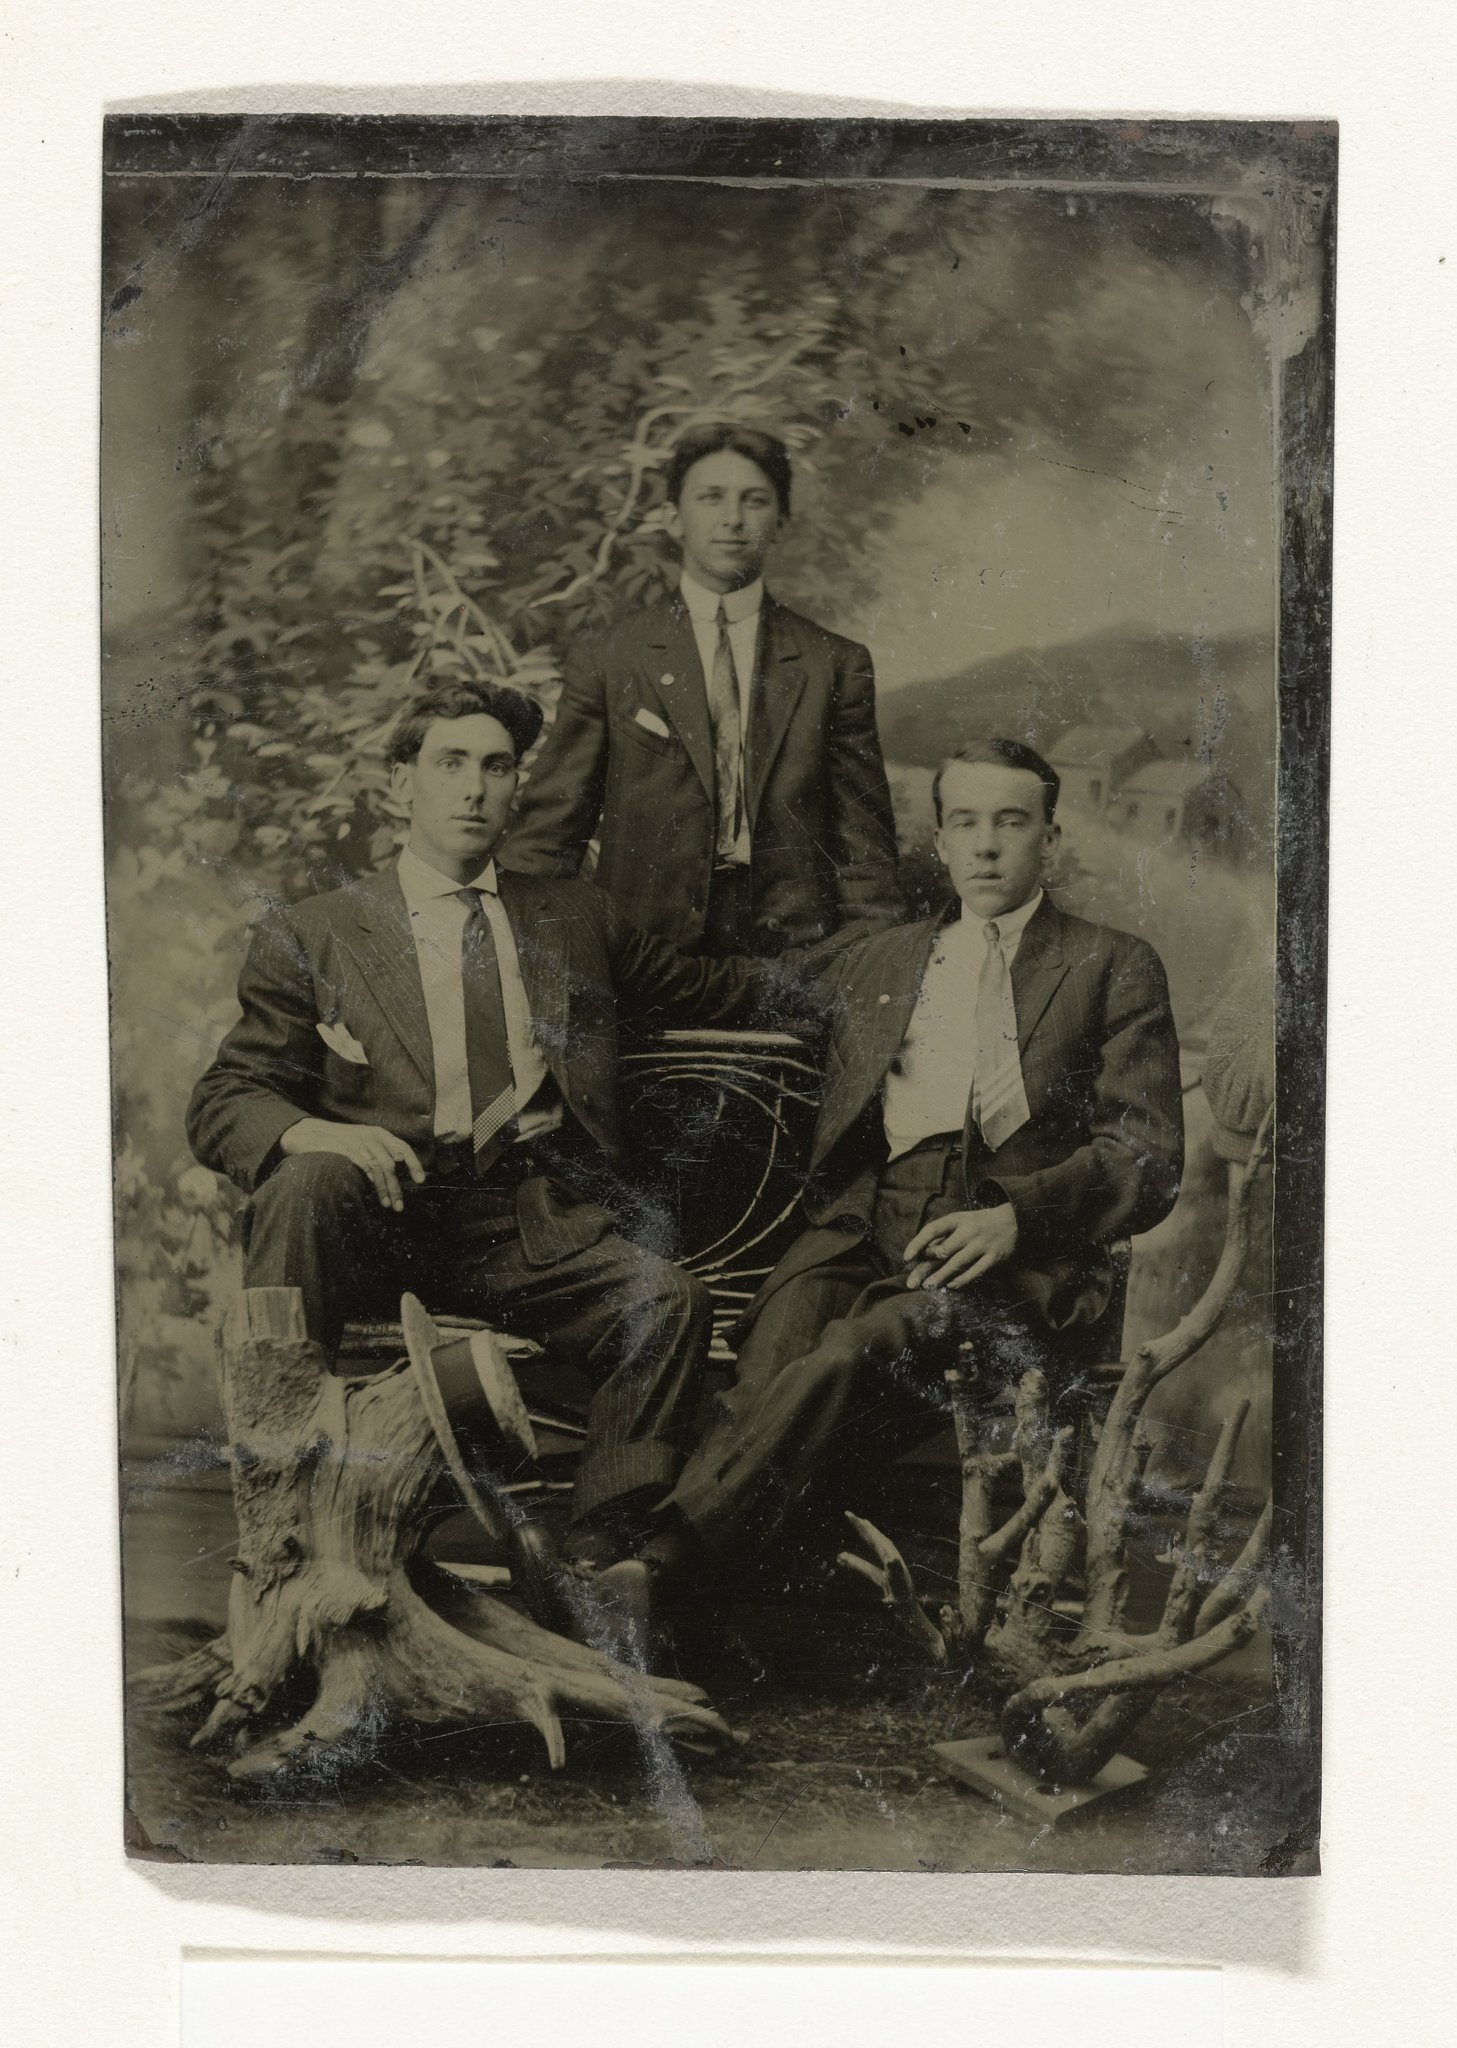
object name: photograph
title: Portret van drie mannen, van wie er twee een sigaar in de hand houden, staand en zittend voor een geschilderd achtergronddoek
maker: Anonymous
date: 1870-1900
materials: metal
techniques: ferrotyping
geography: united states